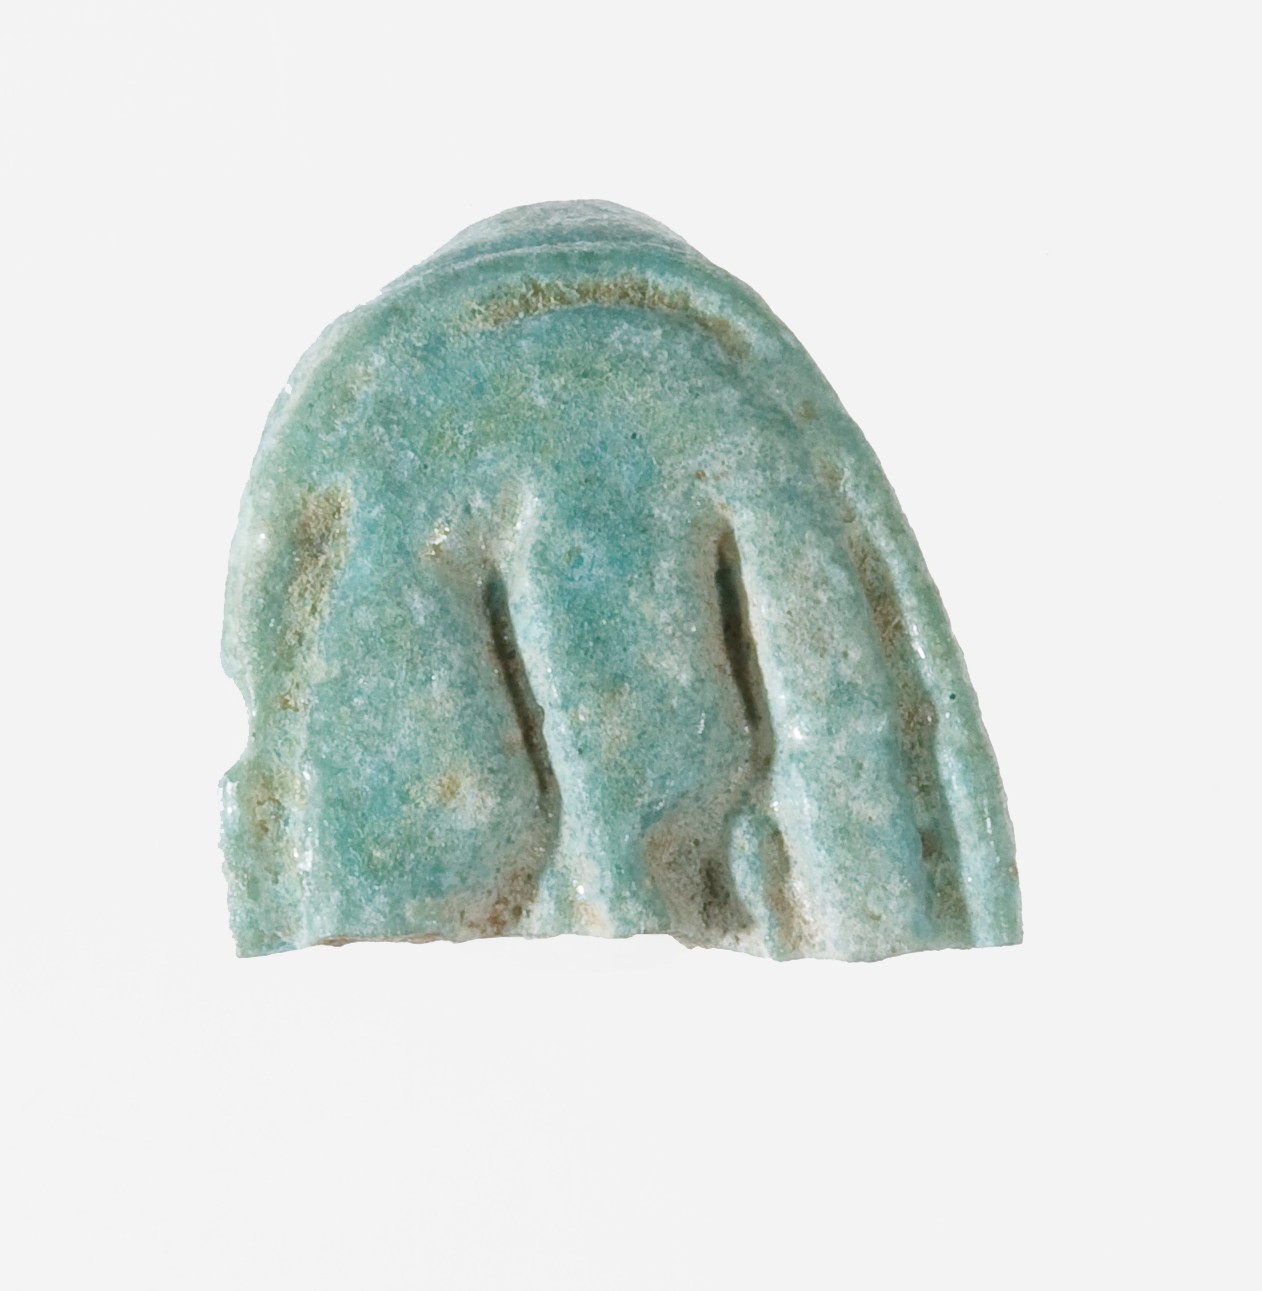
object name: ring fragment, tiy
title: Ring Fragment with last letter of name Tiy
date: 1390-1352 BCE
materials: faience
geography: egypt